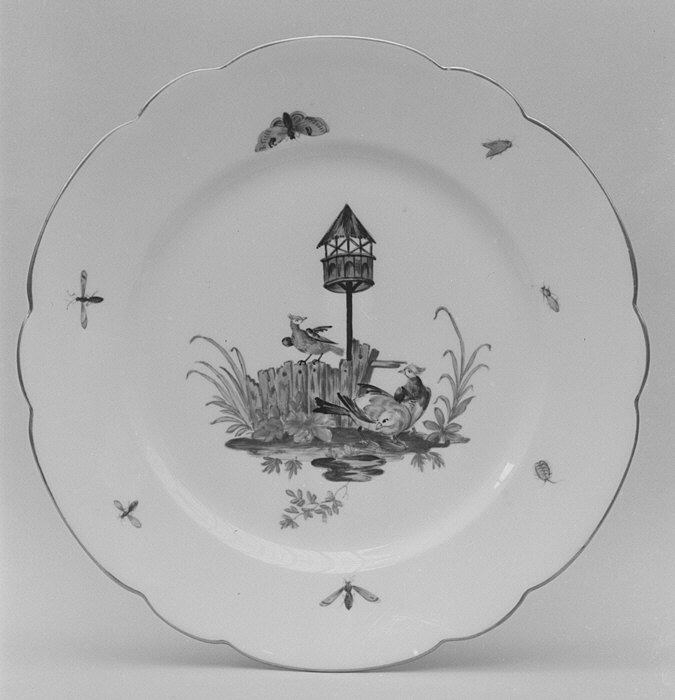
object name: plate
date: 1801-1900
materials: hard paste porcelain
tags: birds,insects